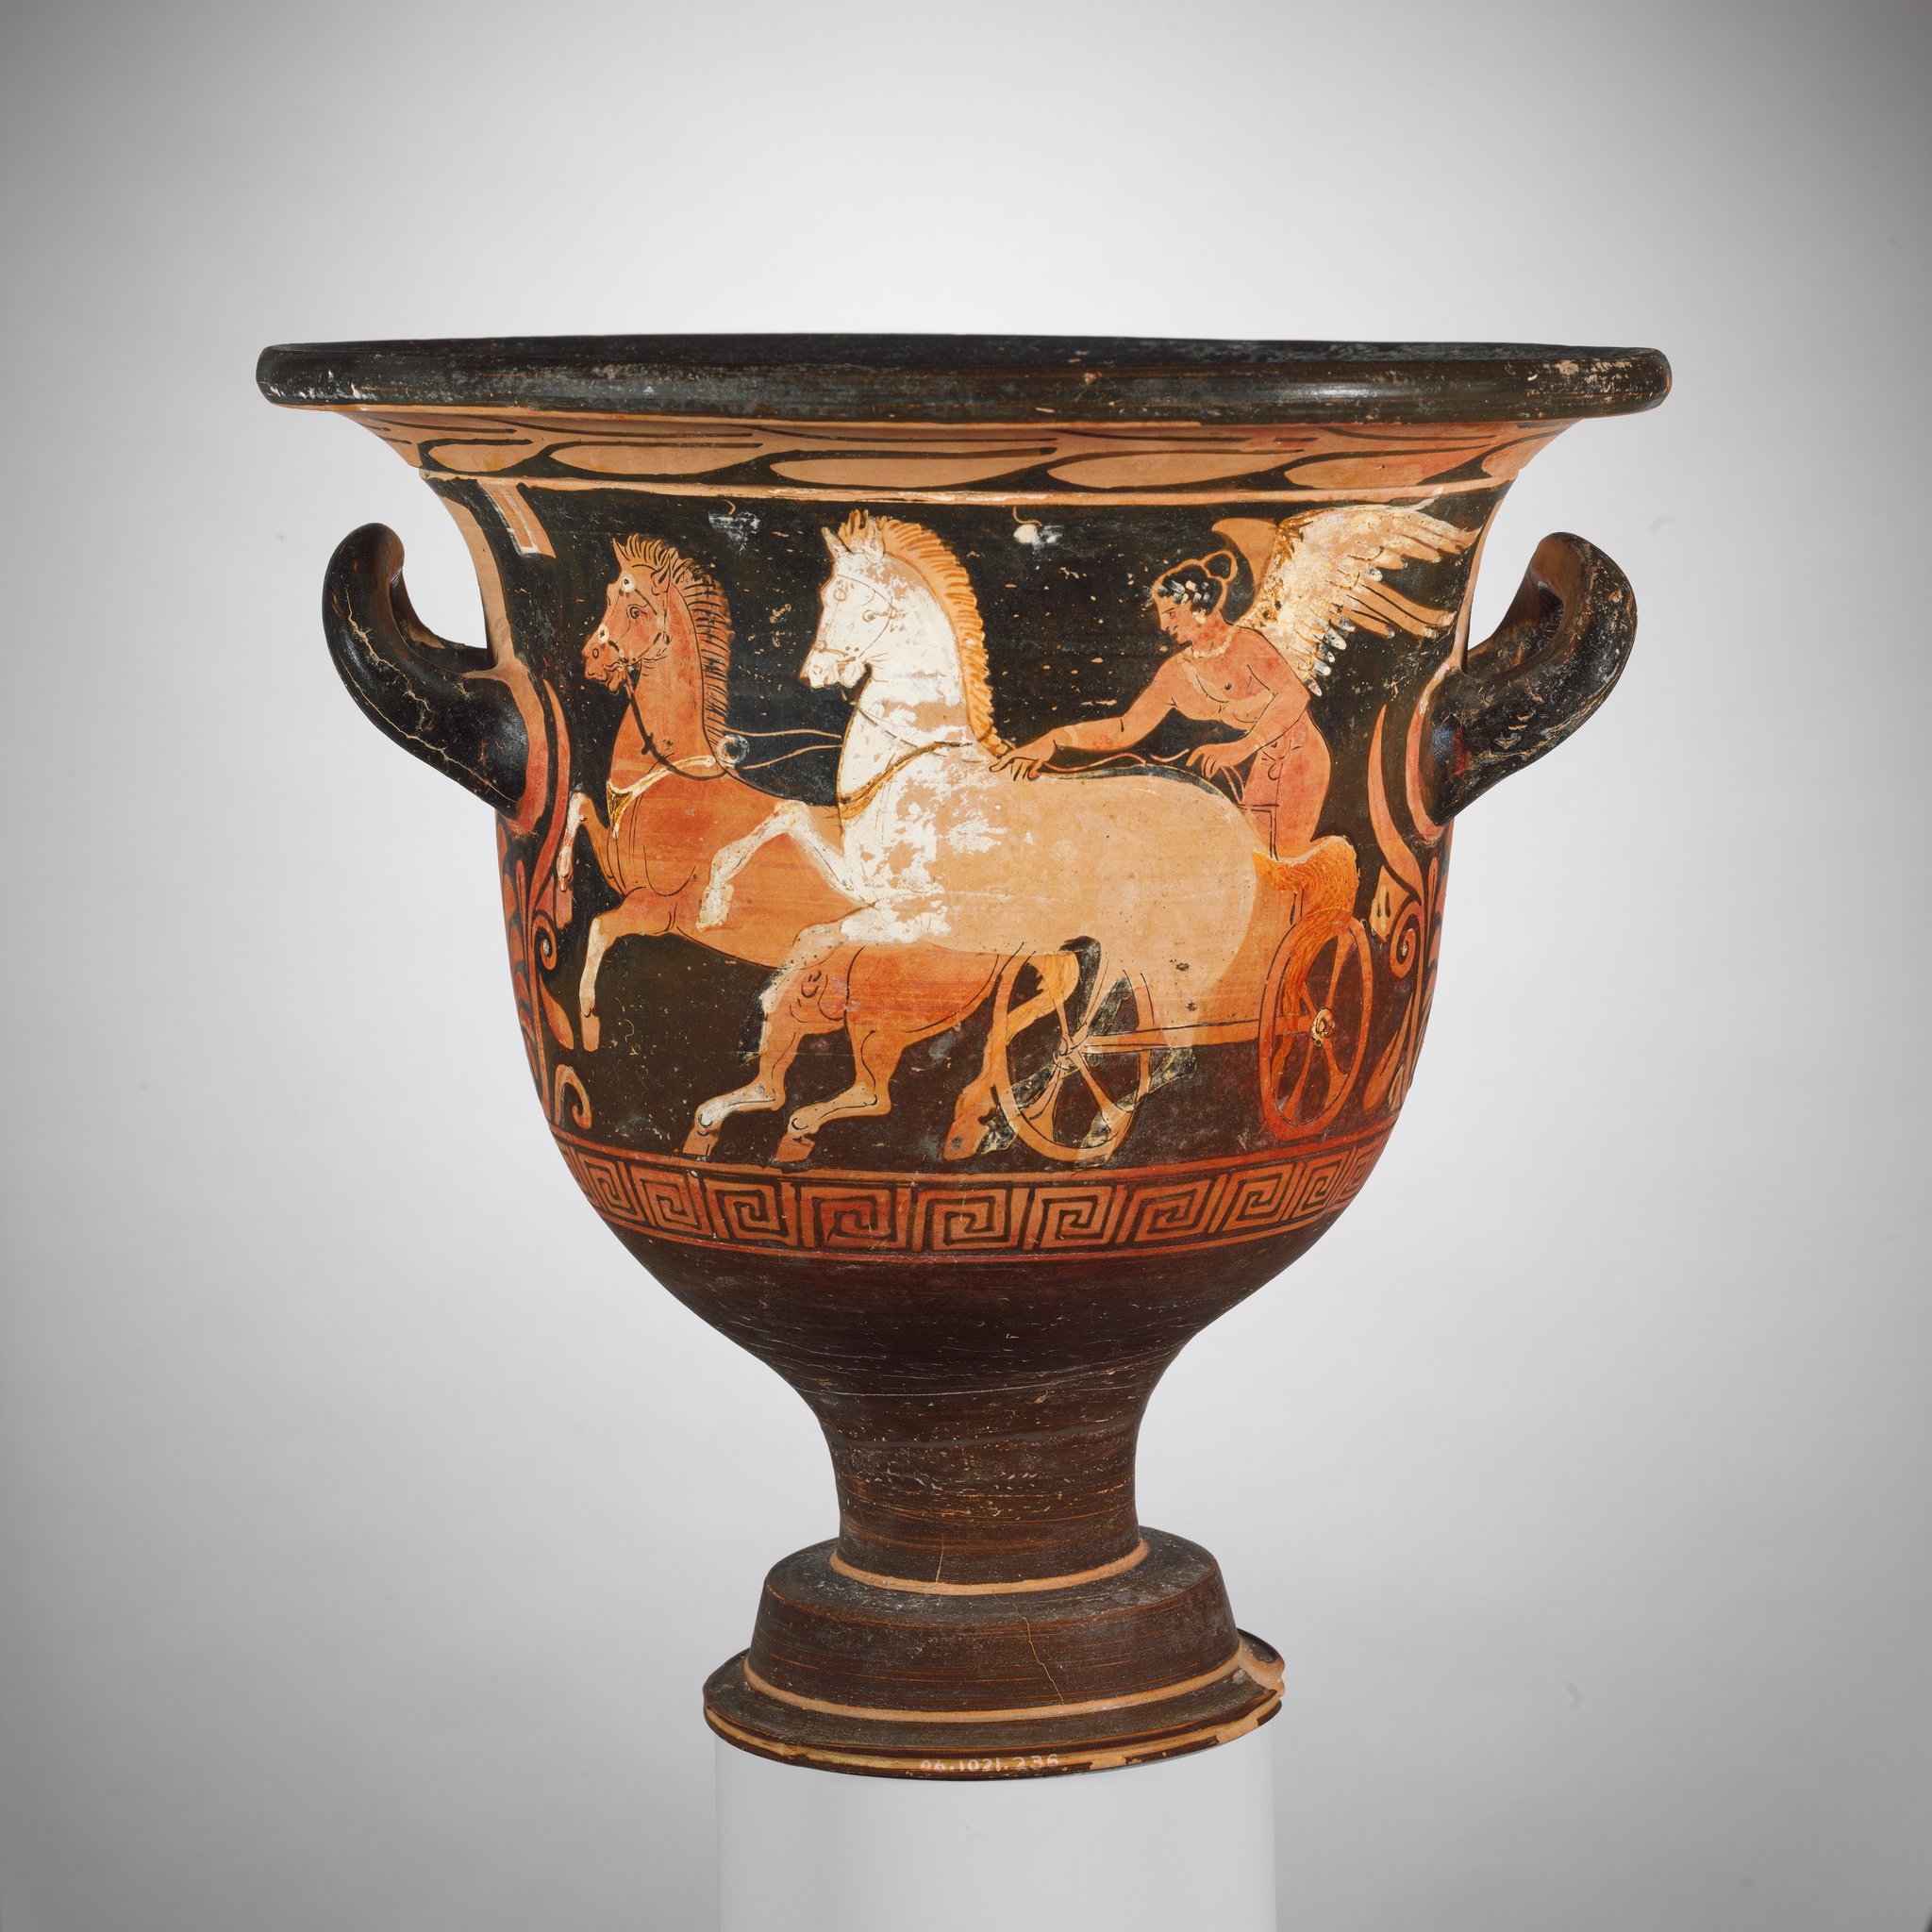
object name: bell krater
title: Terracotta bell-krater (mixing bowl)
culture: greek or south italian or campanian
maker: whiteface painter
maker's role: artist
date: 360-330 BCE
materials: terracotta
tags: men,eros,horses,chariots